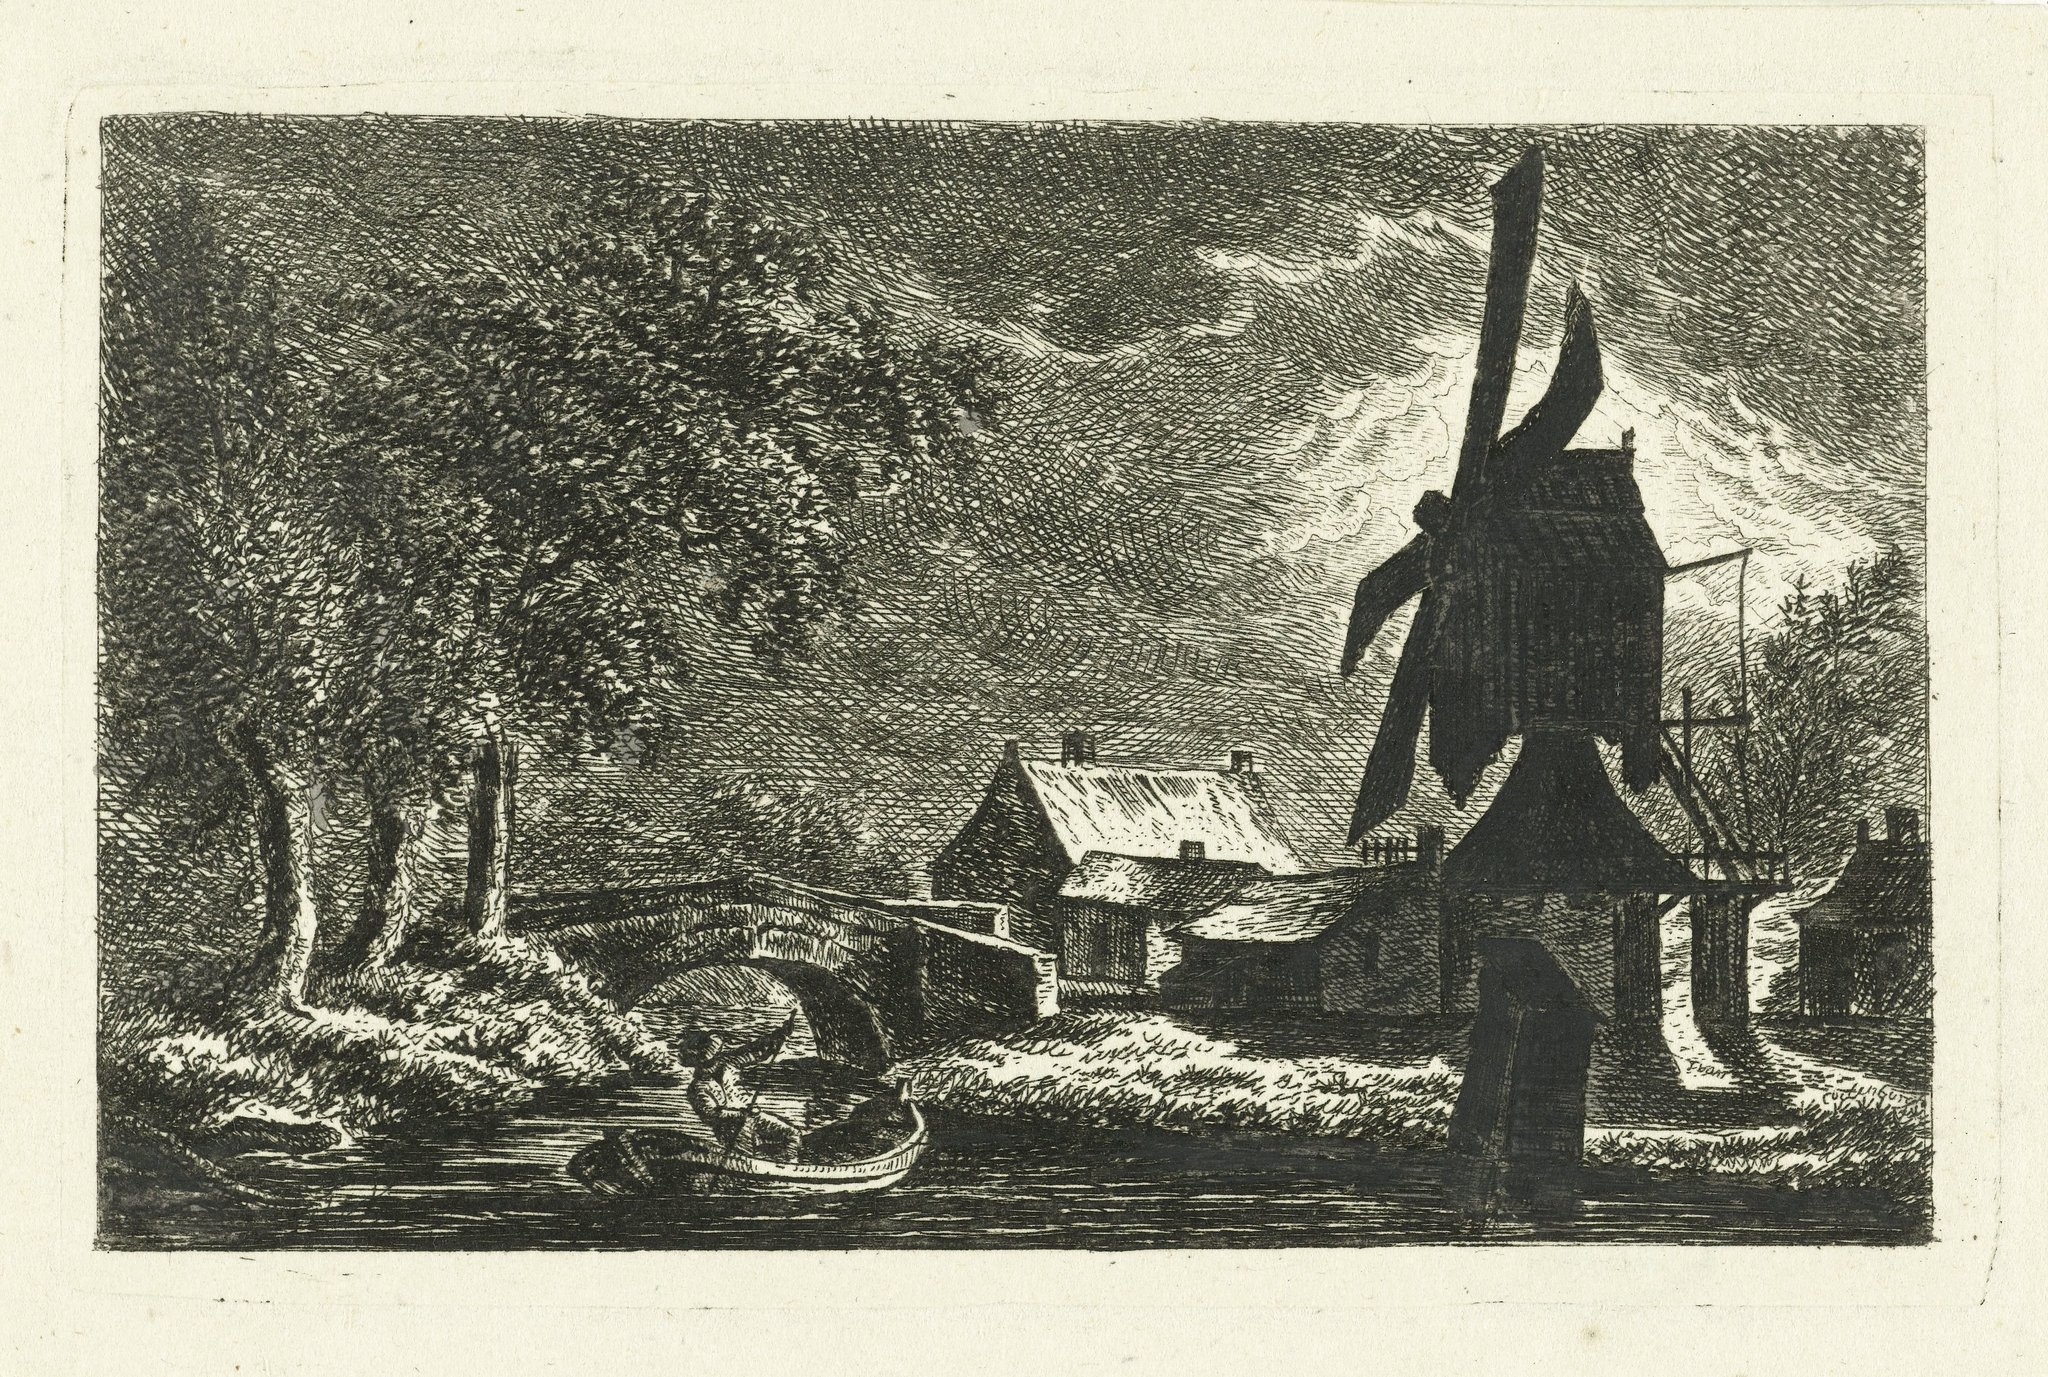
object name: print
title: Landschap met molen bij maanlicht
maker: johannes van cuylenburgh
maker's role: print maker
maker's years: 1793-1841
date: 1803-1841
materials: paper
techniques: etching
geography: netherlands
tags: windmill in landscape, night ~ landscape (sometimes titled 'nox')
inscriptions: collector's mark: Lugt 2228